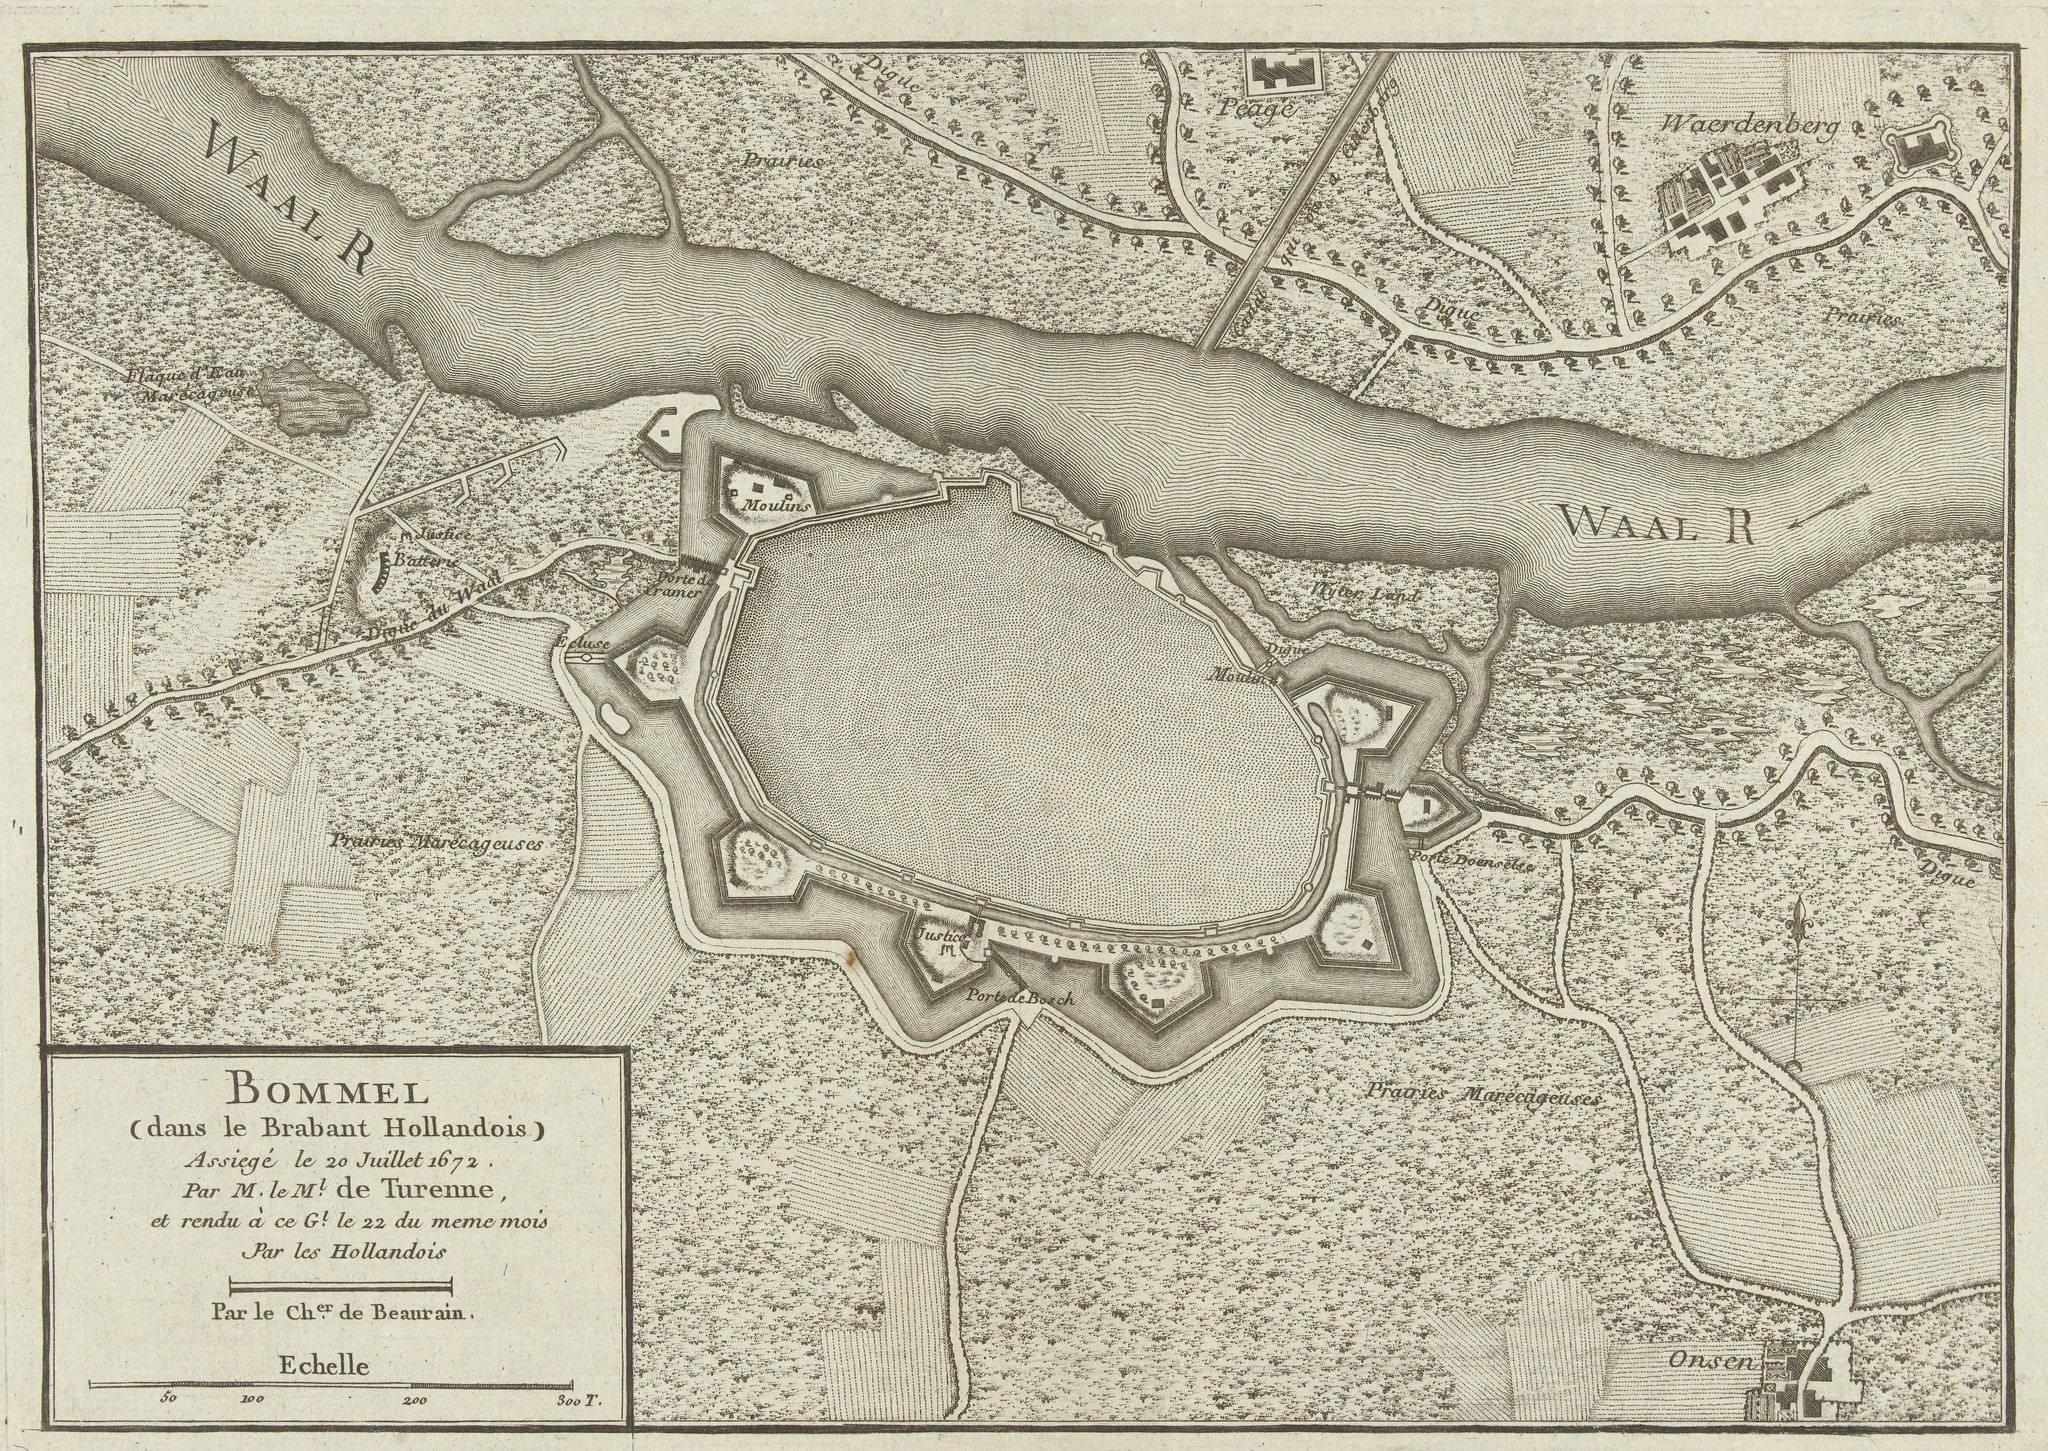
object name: map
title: Kaart van Bommel, veroverd door de Fransen in 1672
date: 1780-1782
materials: paper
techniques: etching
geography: france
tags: maps of cities, rampjaar (disaster year)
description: Waarschijnlijk gebruikt als illustratie in: Philippe Henri, comte de Grimoard en Chevalier de Beaurain, Histoire des quatre dernieres campagnes du Marechal de Turenne, en 1672, 1673, 1674 & 1675..., Chevalier de Beaurain, Parijs 1782. Niet in Frederik Muller; door het RPK toegevoegd nummer.